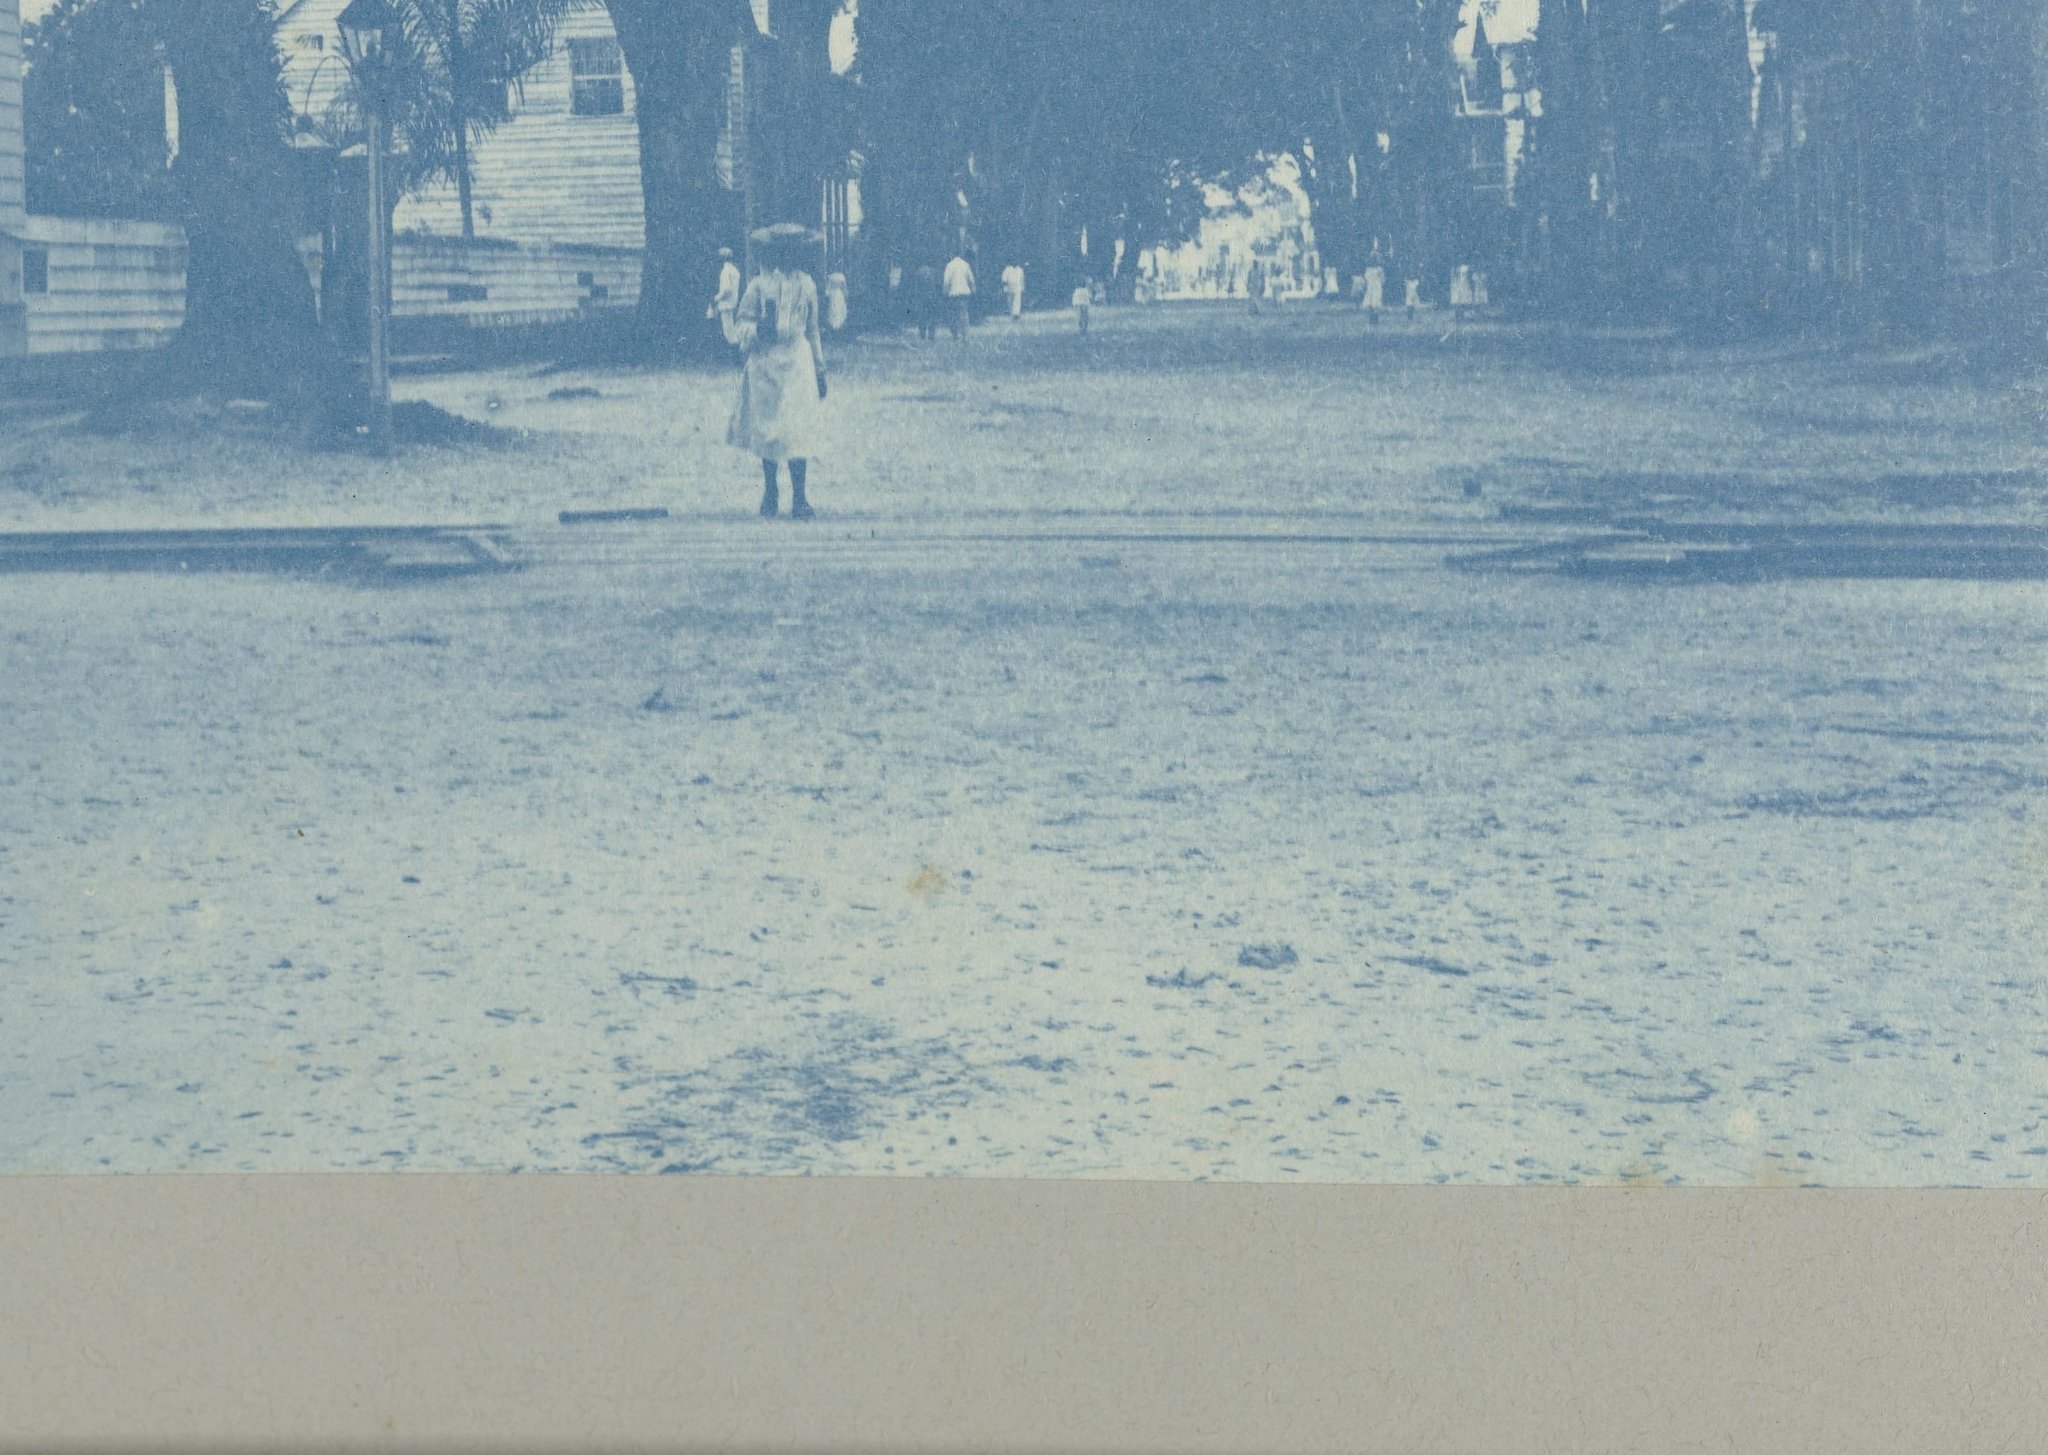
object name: photograph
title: Heerenstraat, Paramaribo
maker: hendrik doijer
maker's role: engineer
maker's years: 1863-1925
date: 1903-1910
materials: photographic support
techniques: cyanotype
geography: suriname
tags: suriname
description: Een vrouw lopend door de Heerenstraat te Paramaribo. Onderdeel van het fotoalbum Souvenir de Voyage (deel 2), over het leven van de familie Doijer in en rond de plantage Ma Retraite in Suriname in de jaren 1903-1910.